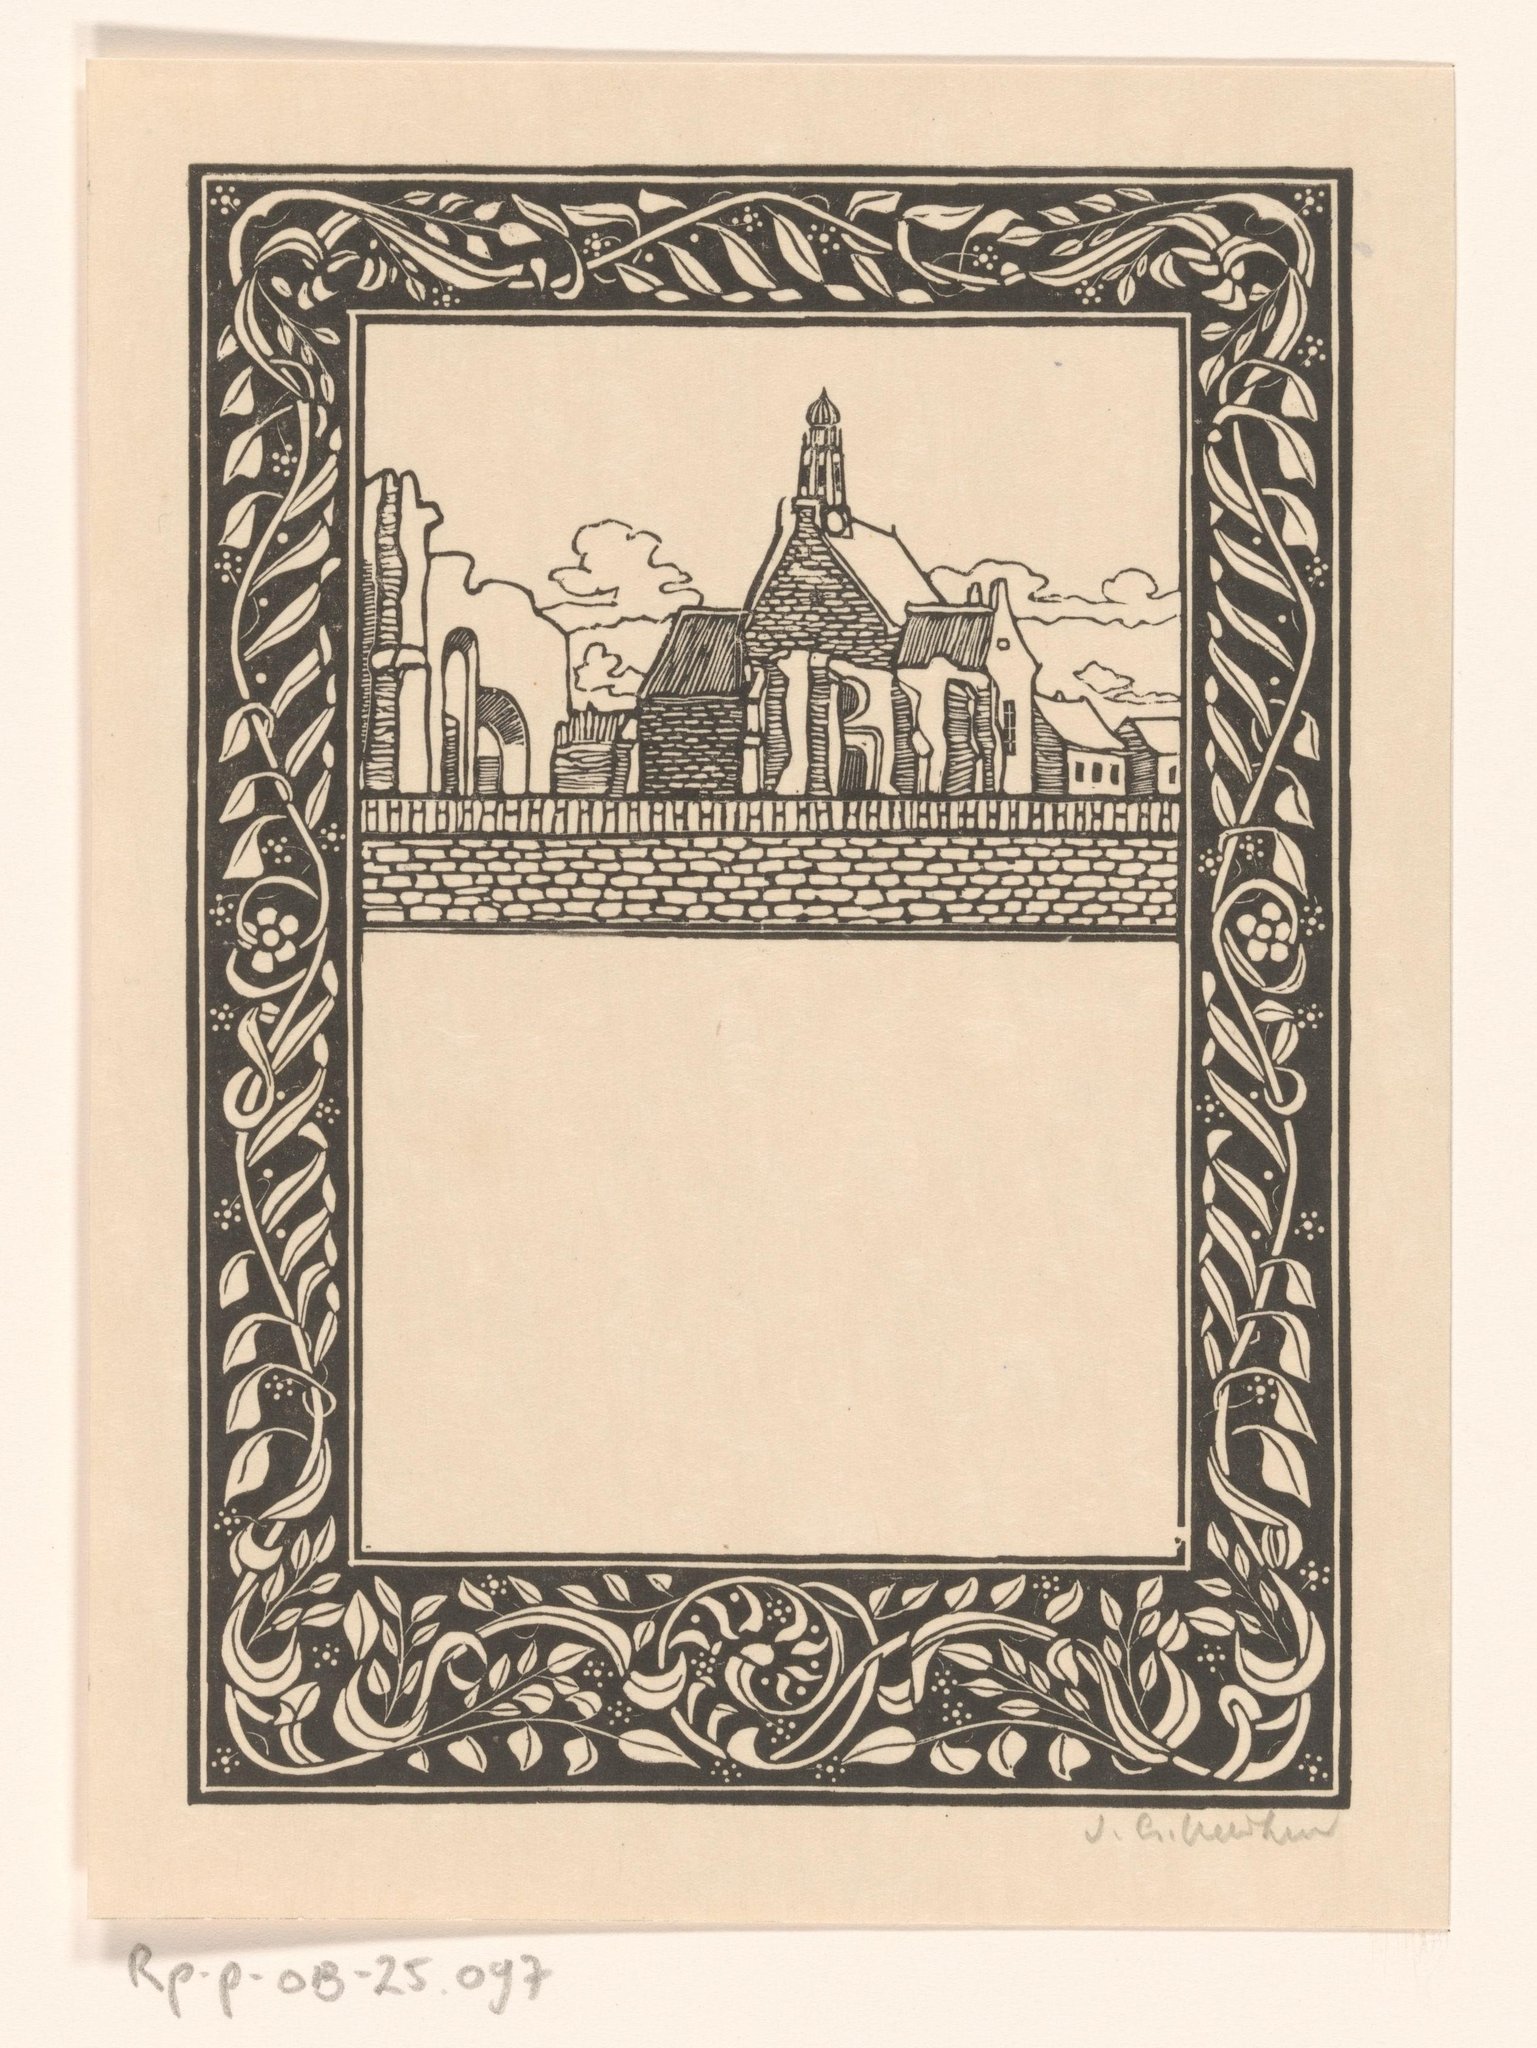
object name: print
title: Kerk in Bergen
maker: jacobus gerardus veldheer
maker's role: draughtsman, print maker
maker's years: 1866-1954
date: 1876-1954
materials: paper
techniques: woodcut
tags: church (exterior)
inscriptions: collector's mark: Lugt 2228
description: Gezicht op een kerk en ruïnes, daaromheen een sierrand met bladeren.